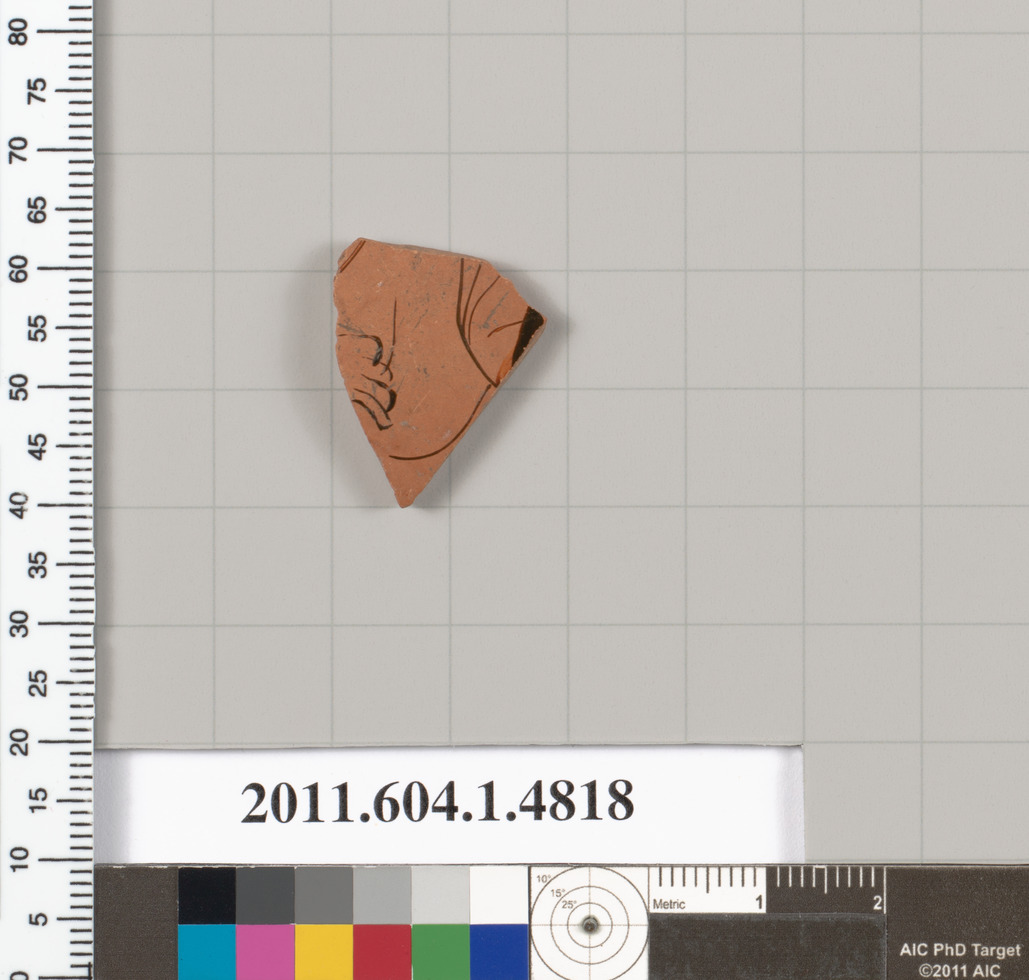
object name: kylix fragment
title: Terracotta fragment of a kylix (drinking cup)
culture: greek, attic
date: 475-451 BCE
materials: terracotta